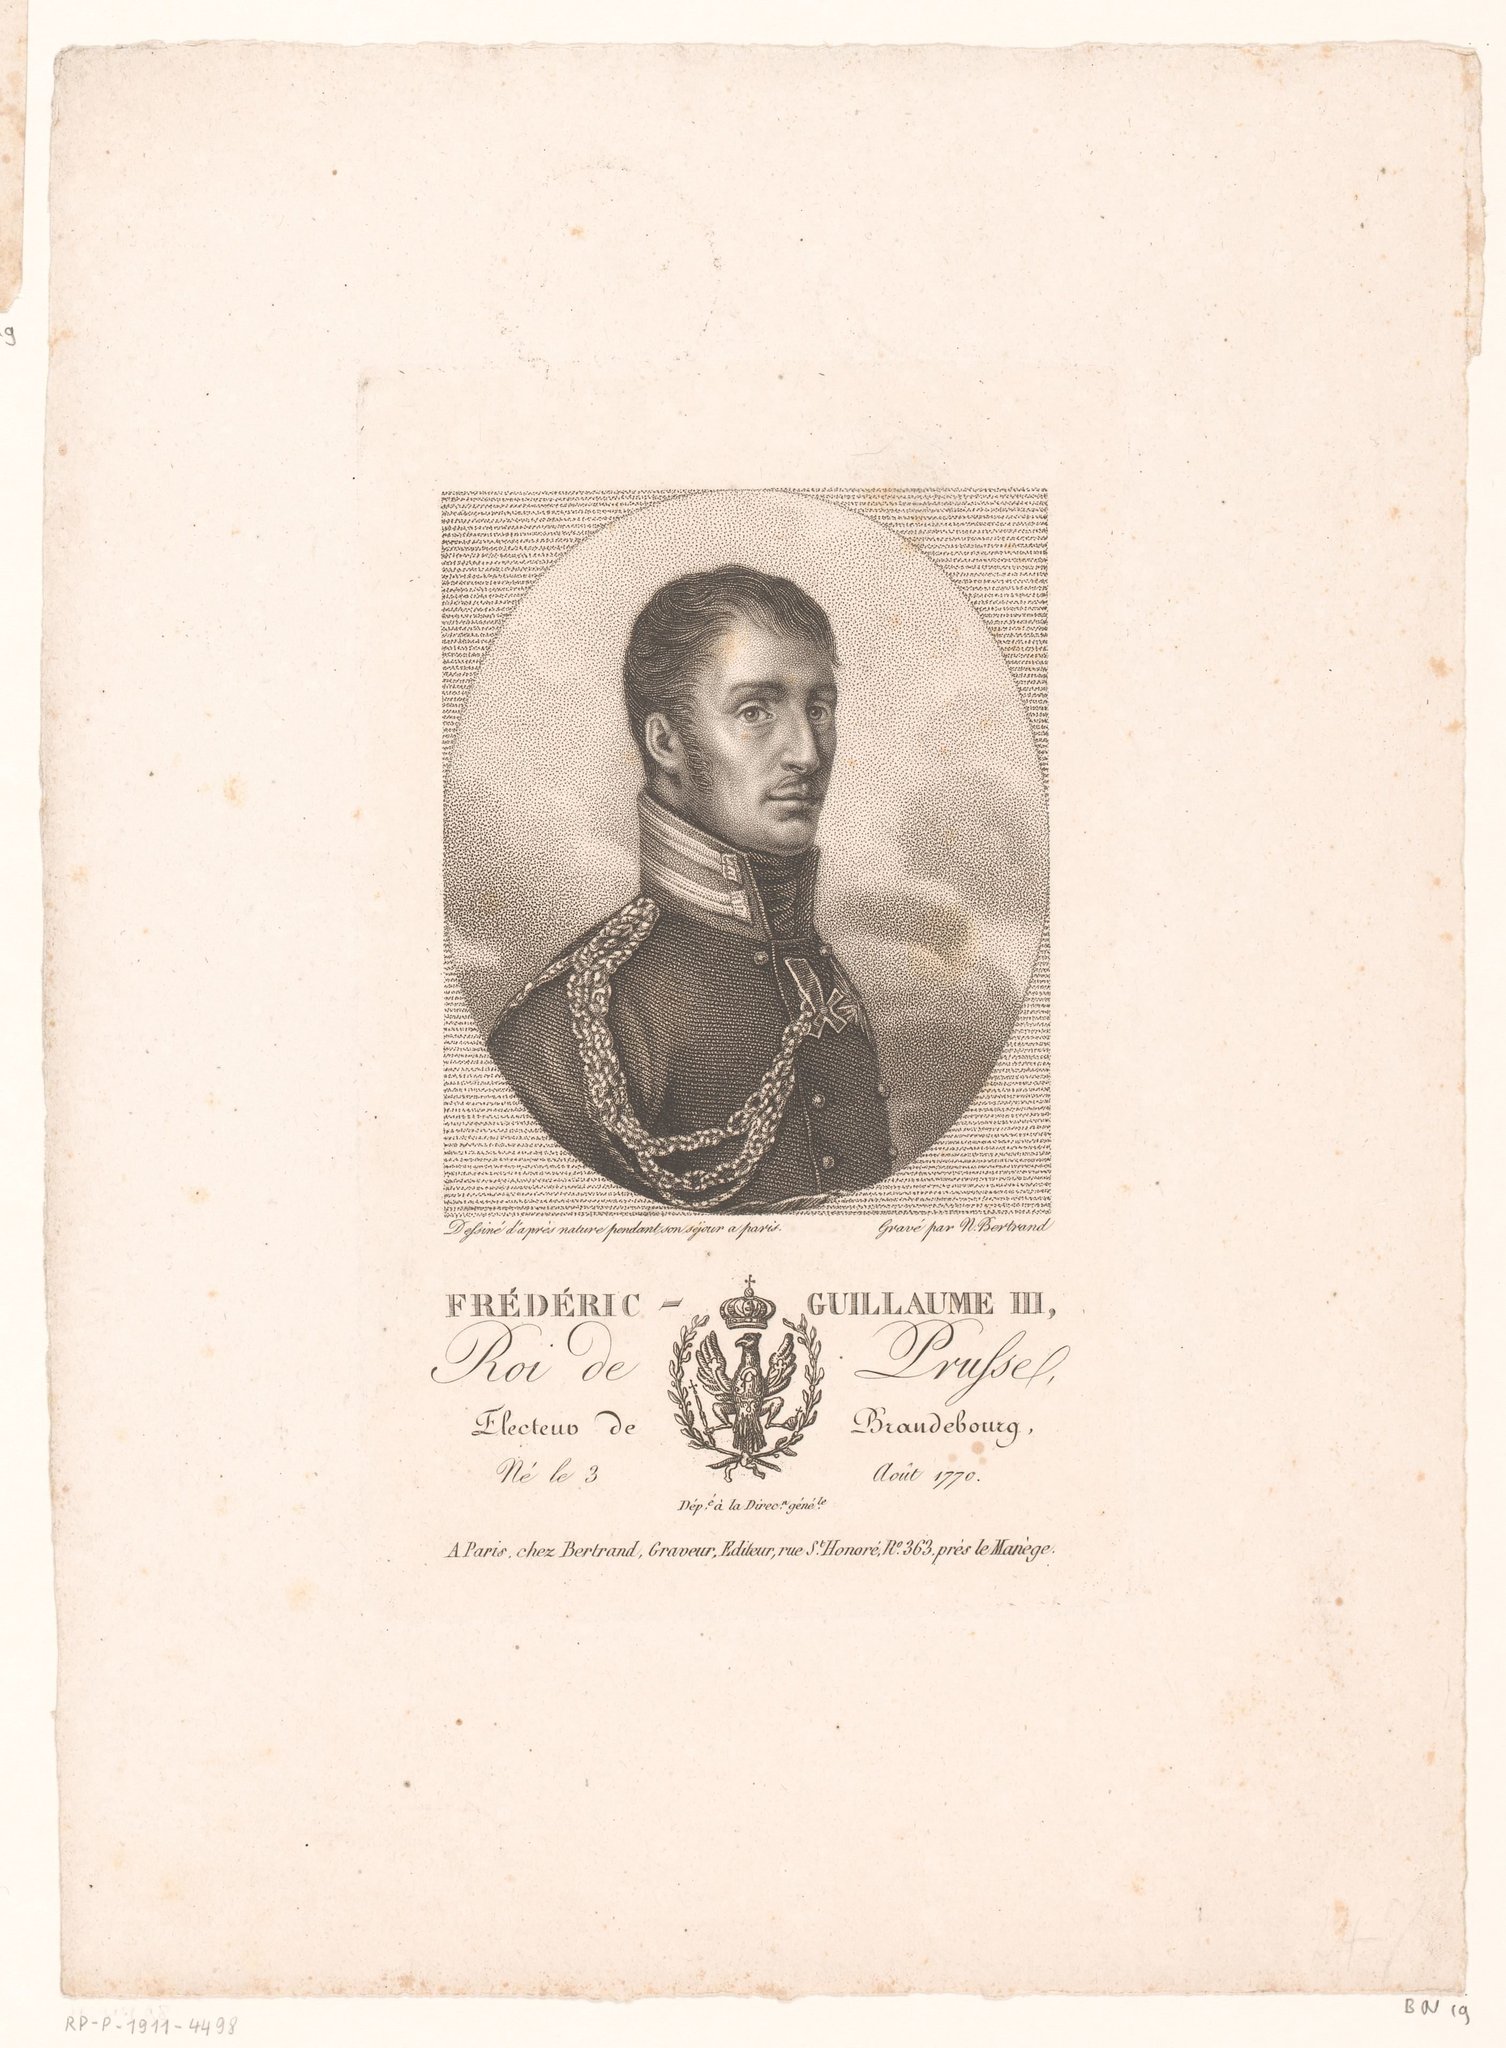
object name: print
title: Portret van Frederik Willem III van Pruisen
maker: noël françois bertrand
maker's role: print maker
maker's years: 1785-1852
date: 1814-1815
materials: paper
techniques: etching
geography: paris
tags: berlin, frederik willem iii koning van pruisen, historical persons, armorial bearing, heraldry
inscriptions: collector's mark: Lugt 2228